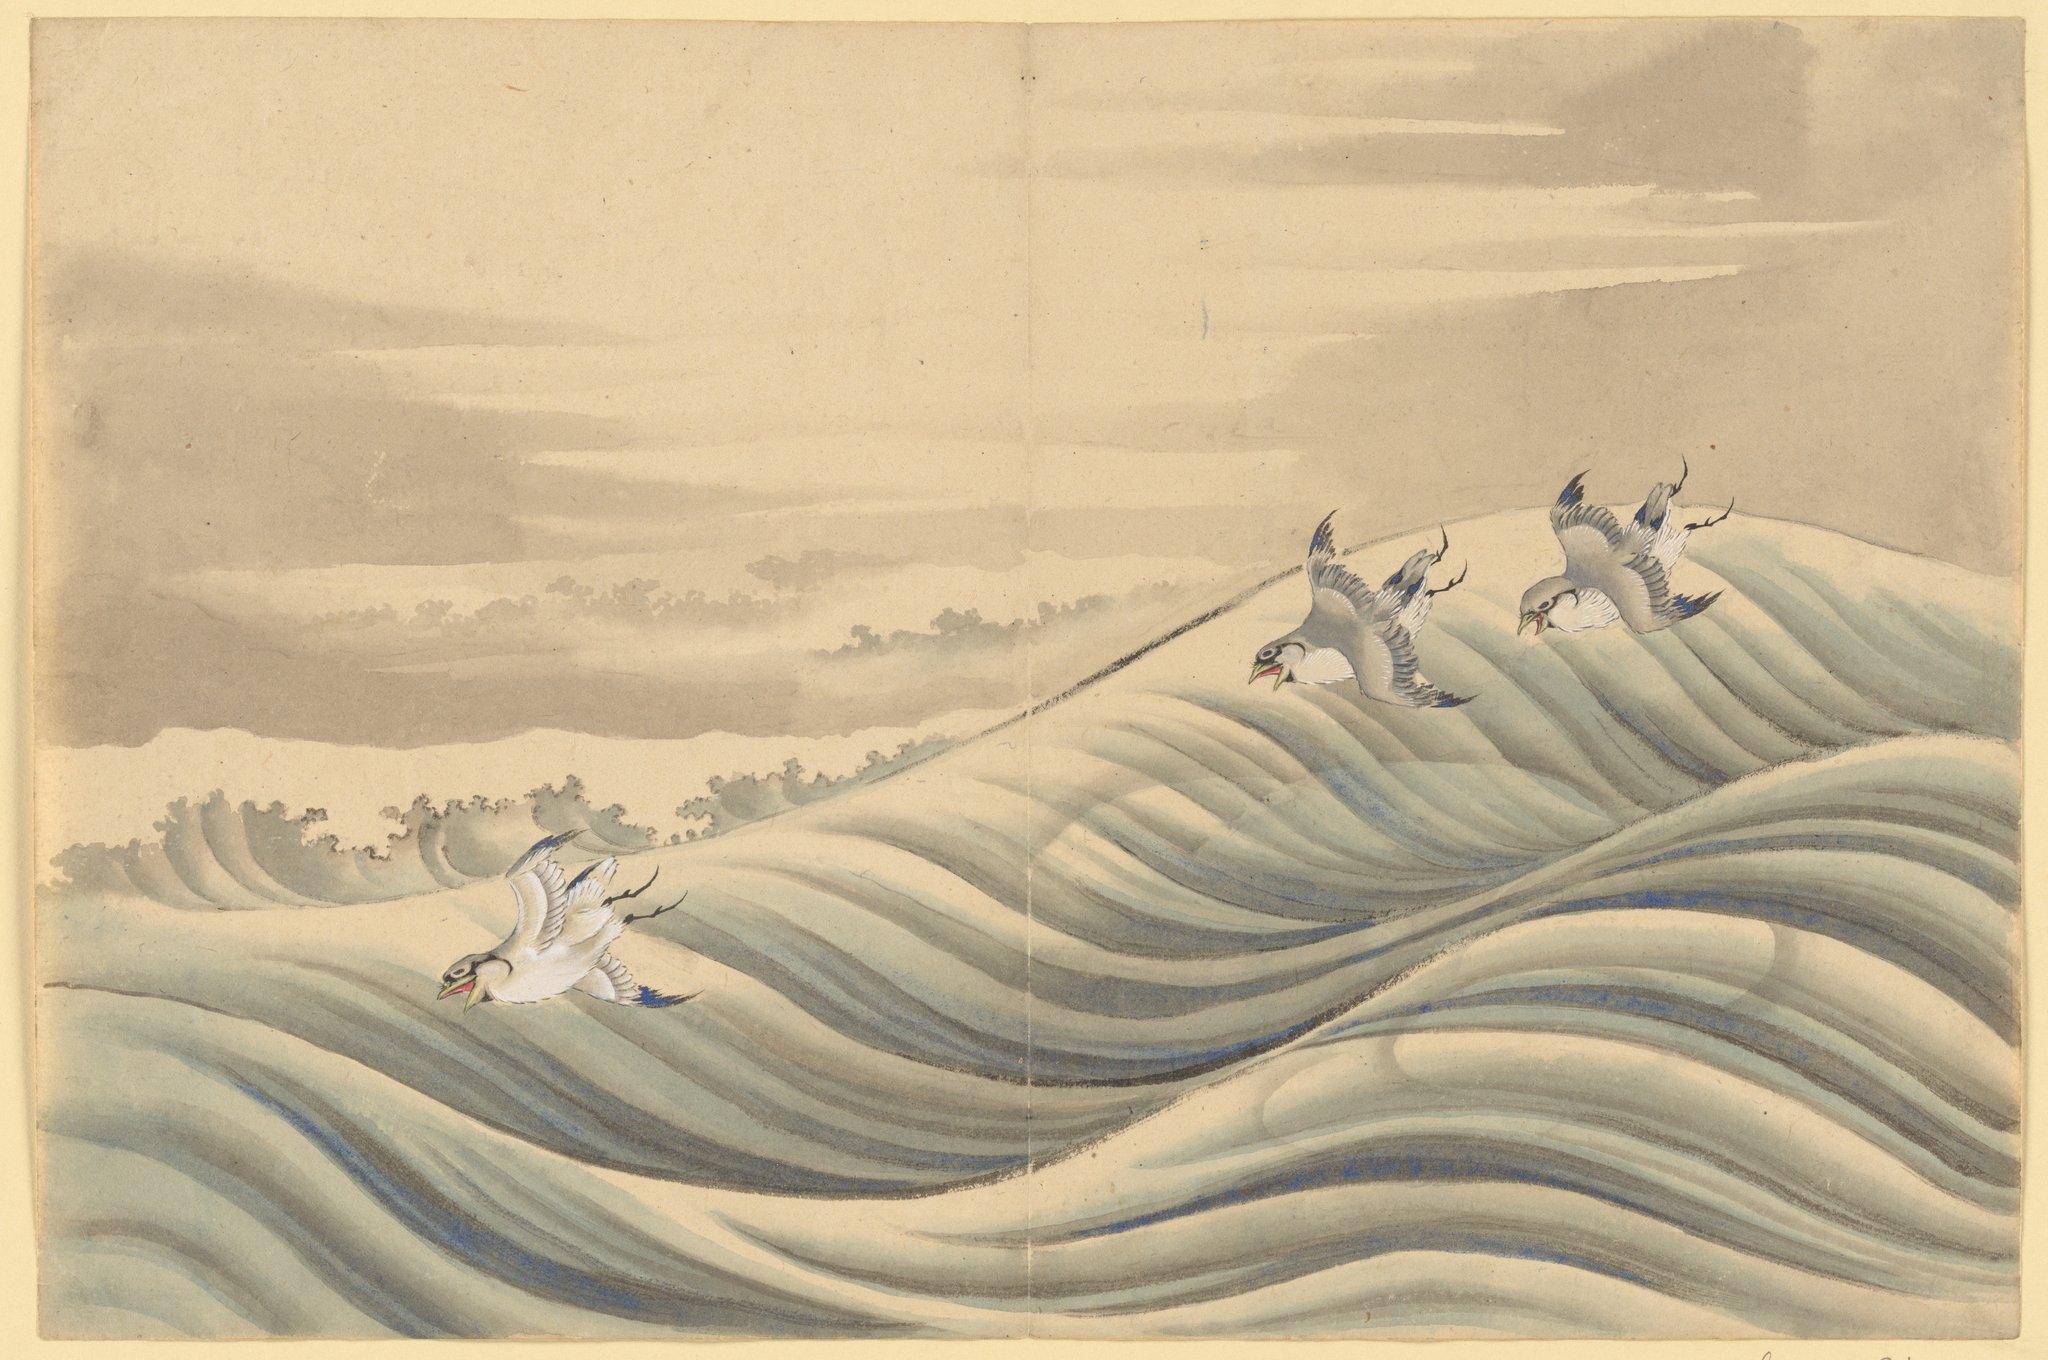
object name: drawing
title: Chidori Birds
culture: japanese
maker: katsushika hokusai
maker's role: artist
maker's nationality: japanese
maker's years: 1760-1849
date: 1701-1900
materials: ink, paper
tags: birds,waves